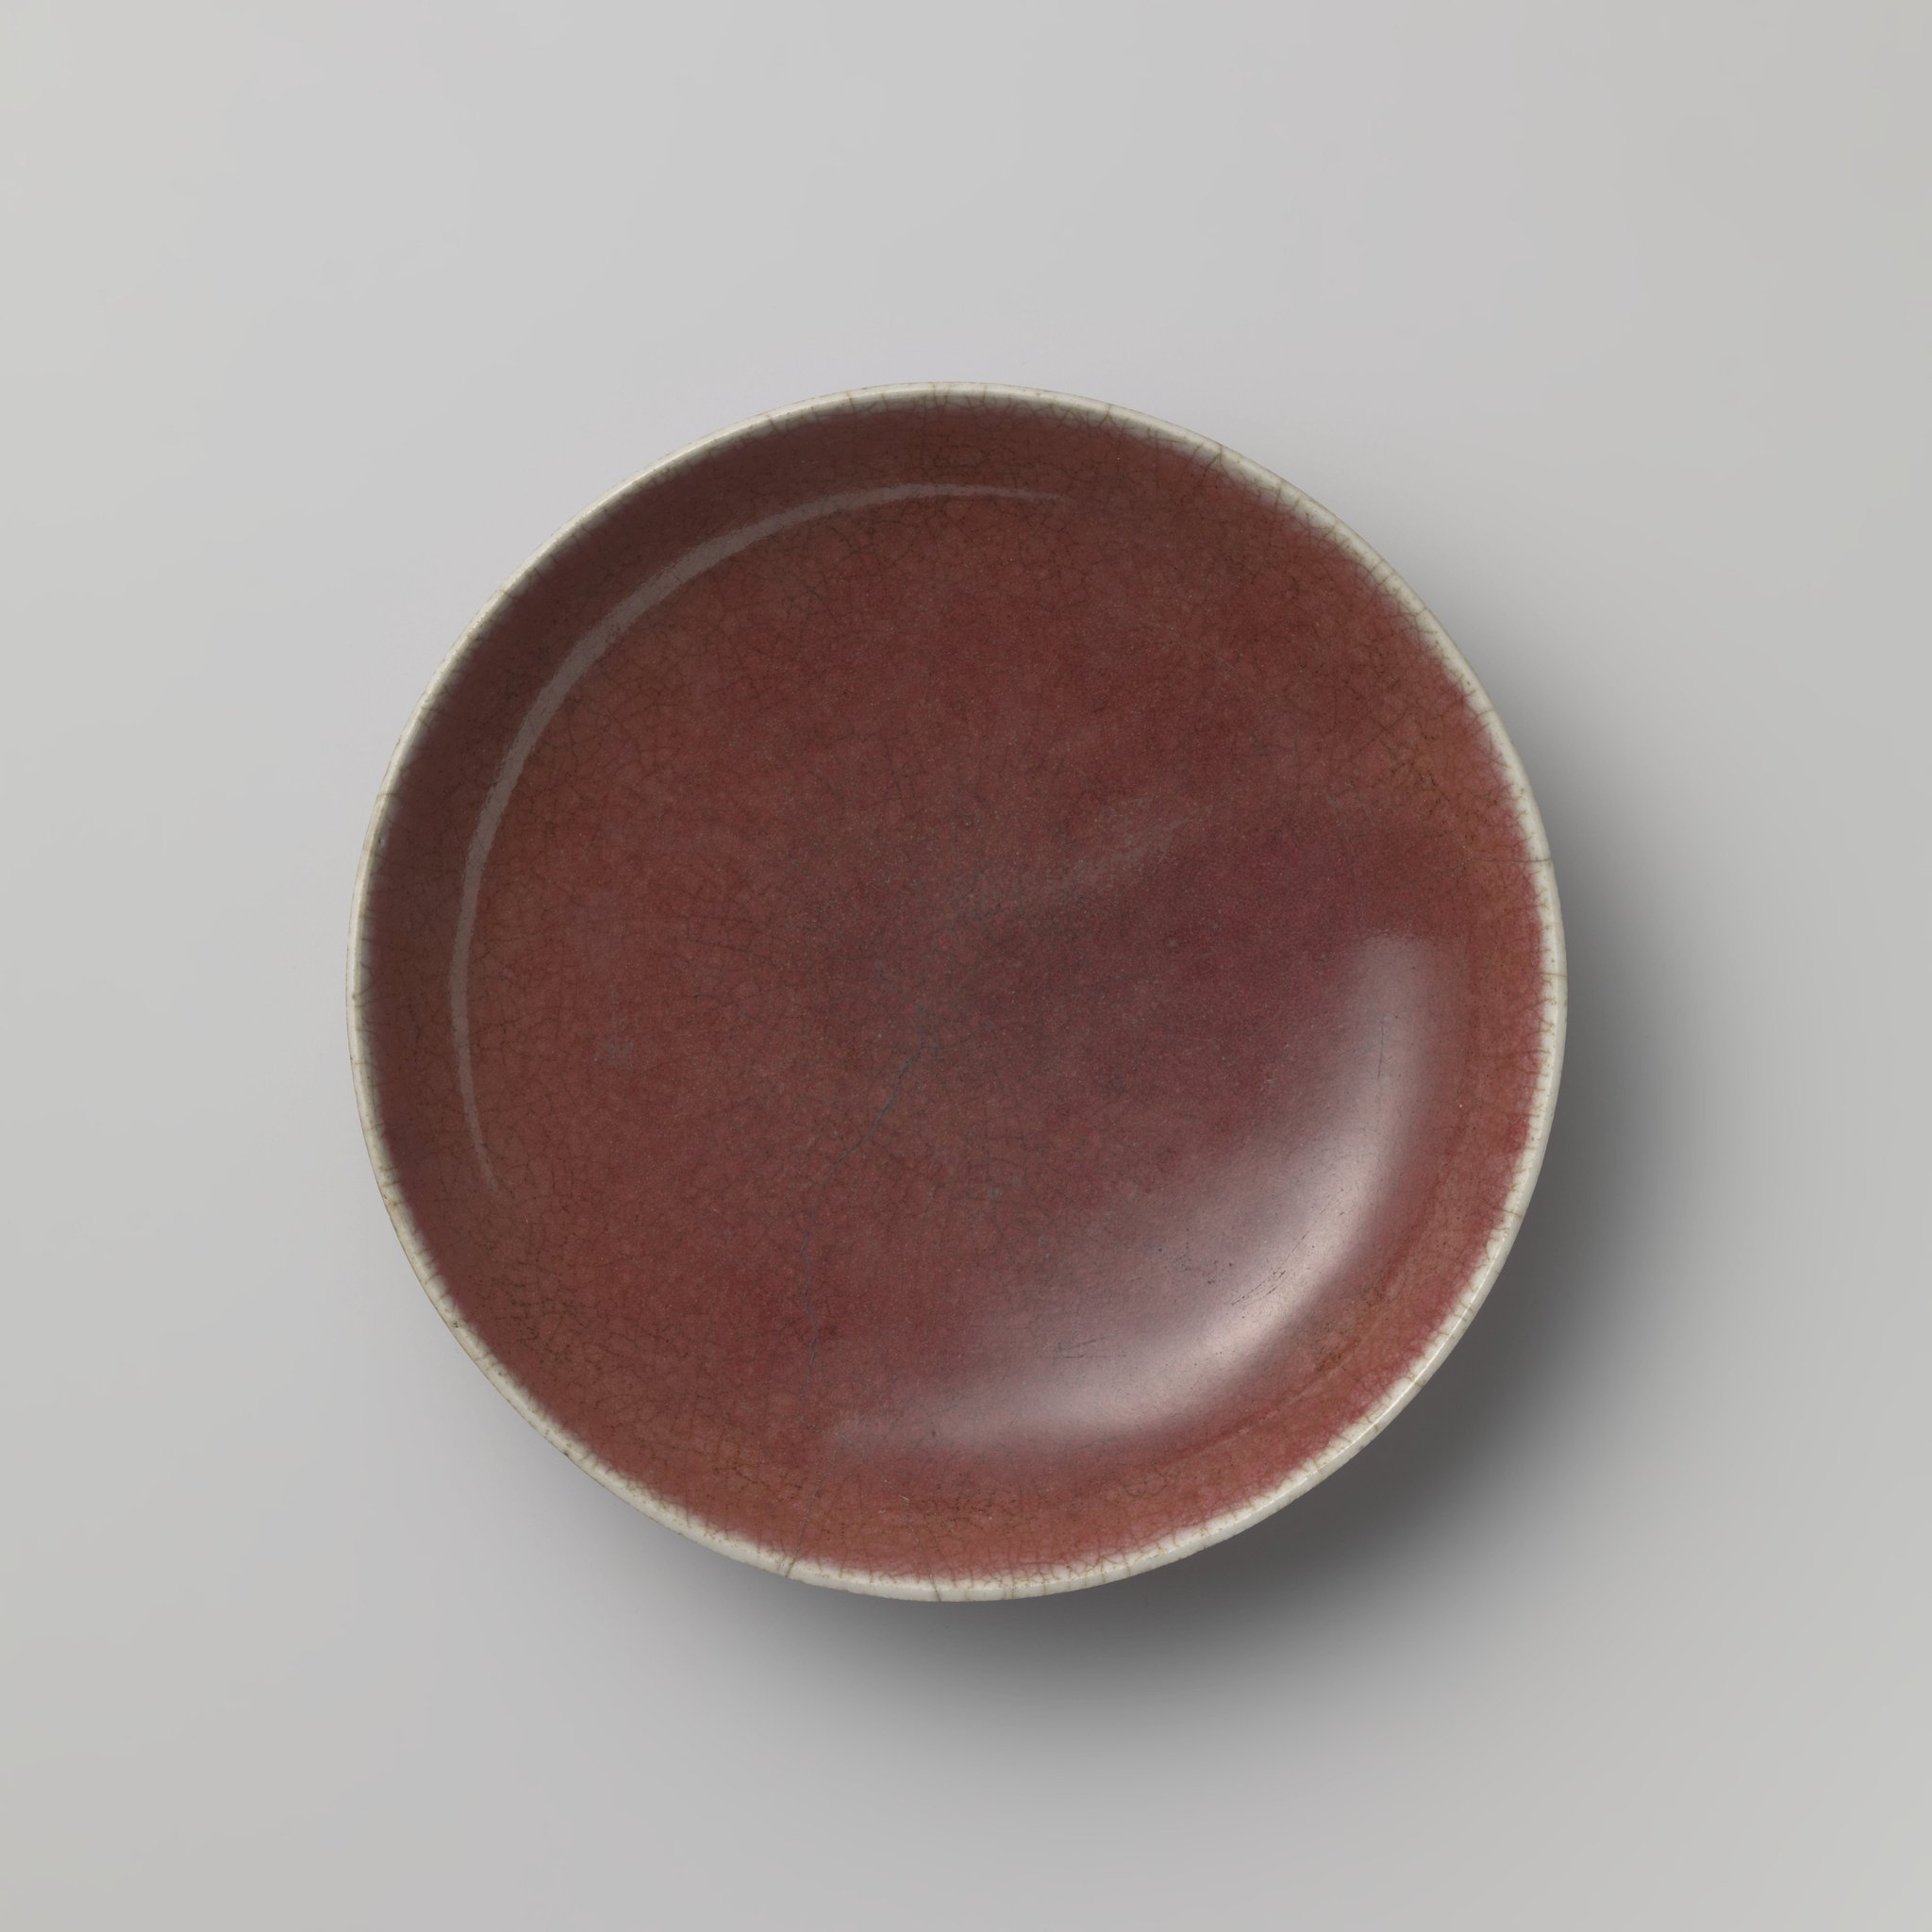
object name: dish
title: Saucer dish with a crackled red glaze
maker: Anonymous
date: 1800-1899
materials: glaze, porcelain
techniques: firing, turning, vitrification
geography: china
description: Schaal van porselein met ronde wand, bedekt met een gecraqueleerd rood (sang de boeuf) glazuur, de rand is wit. Binnen de voetring een gecraqueleerd celadonglazuur. Wand is gebroken geweest. Monochromen.